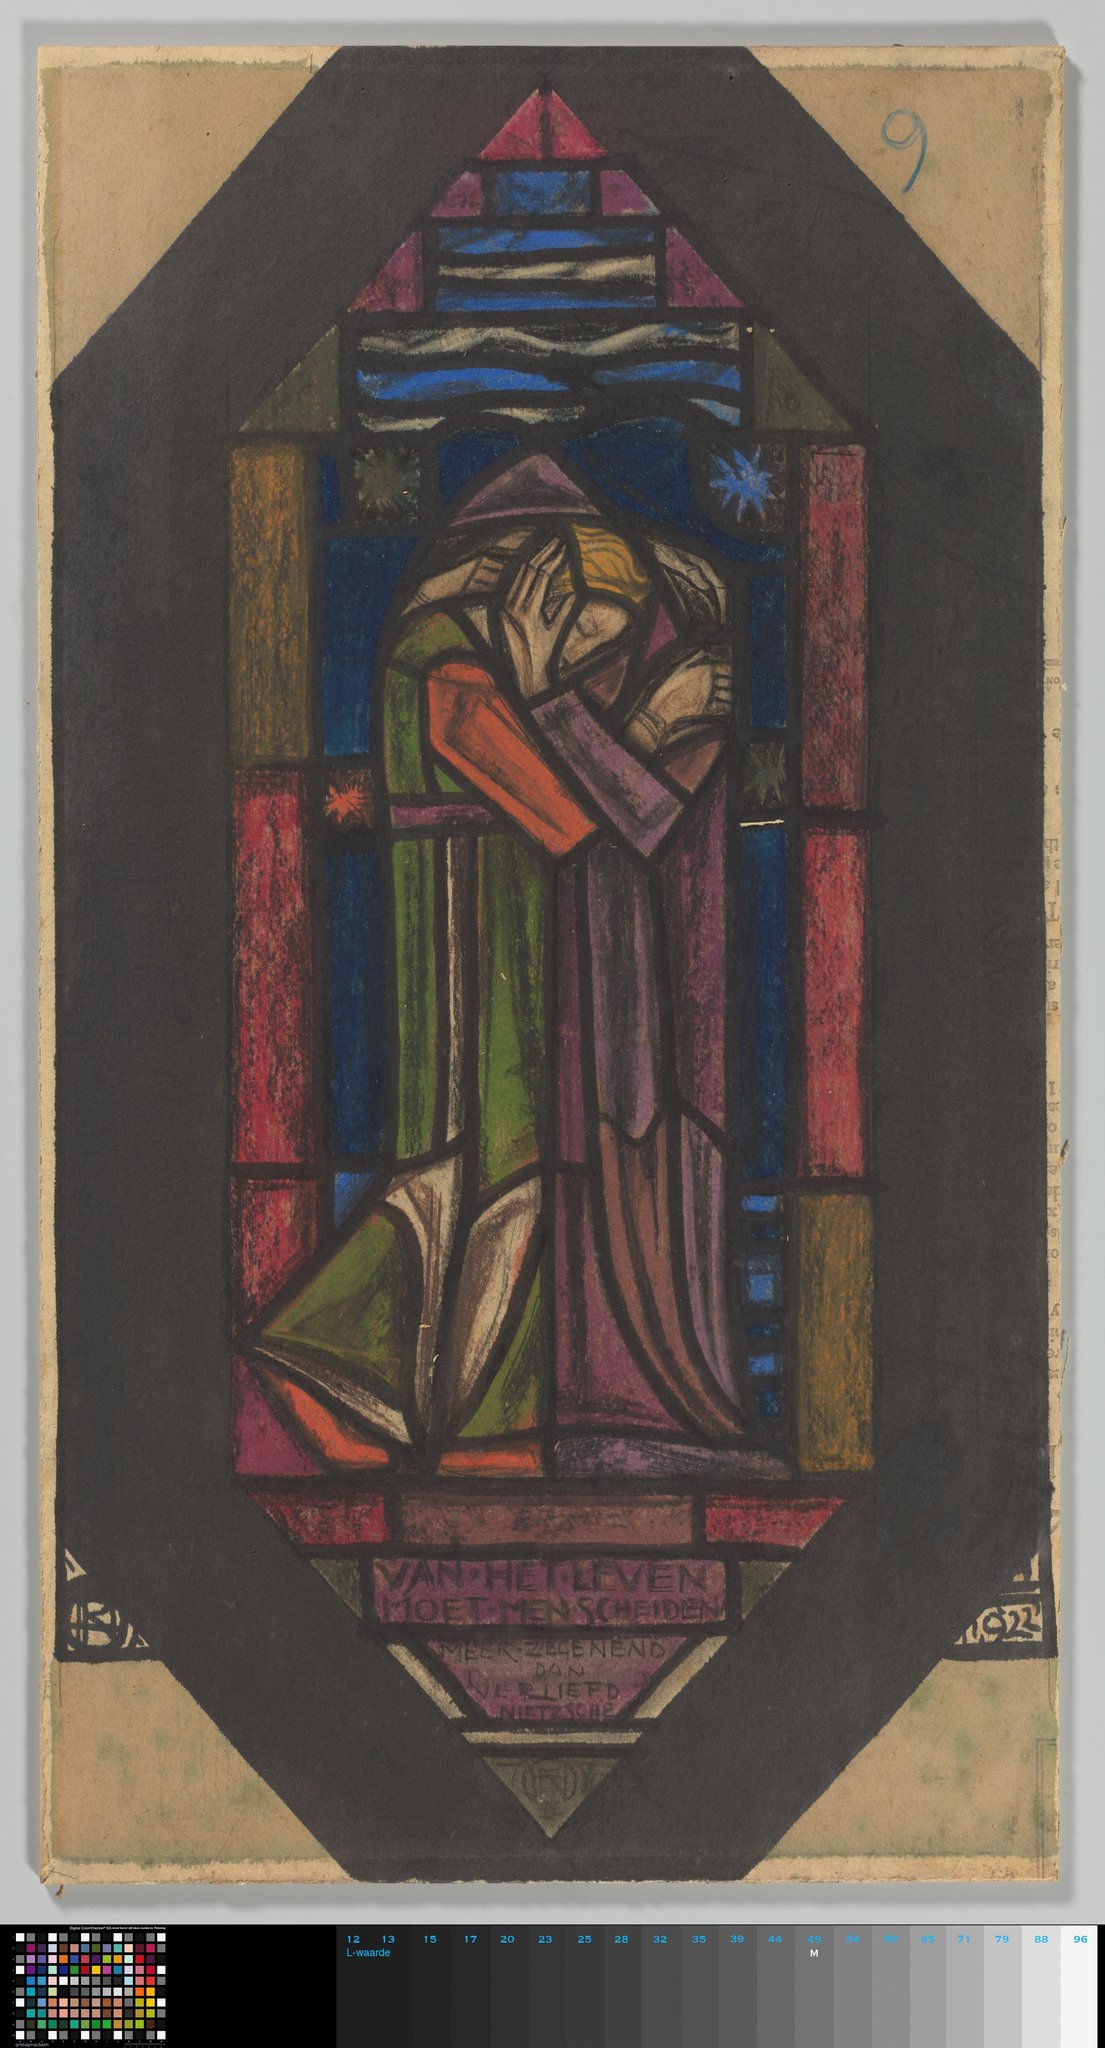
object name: drawing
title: De trap des levens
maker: richard nicolaüs roland holst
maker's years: 1868-1938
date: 1922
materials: cardboard, chalk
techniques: brush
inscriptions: monogram: ‘RNRH’